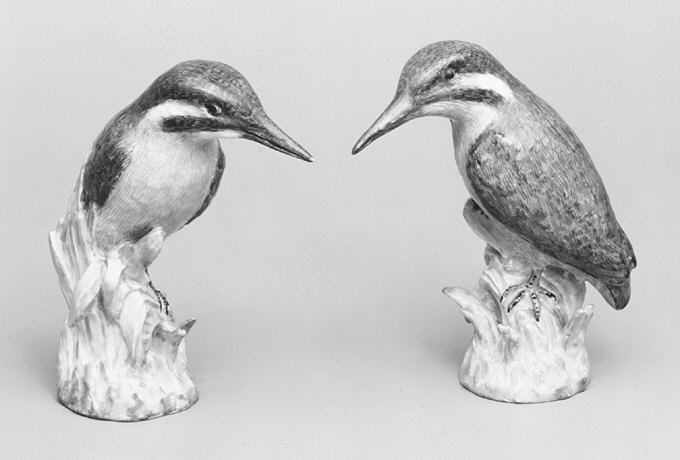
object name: figure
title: Pair of icebirds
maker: royal porcelain manufactory, berlin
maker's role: manufactory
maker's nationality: german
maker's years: 1763-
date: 1760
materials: hard paste porcelain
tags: birds